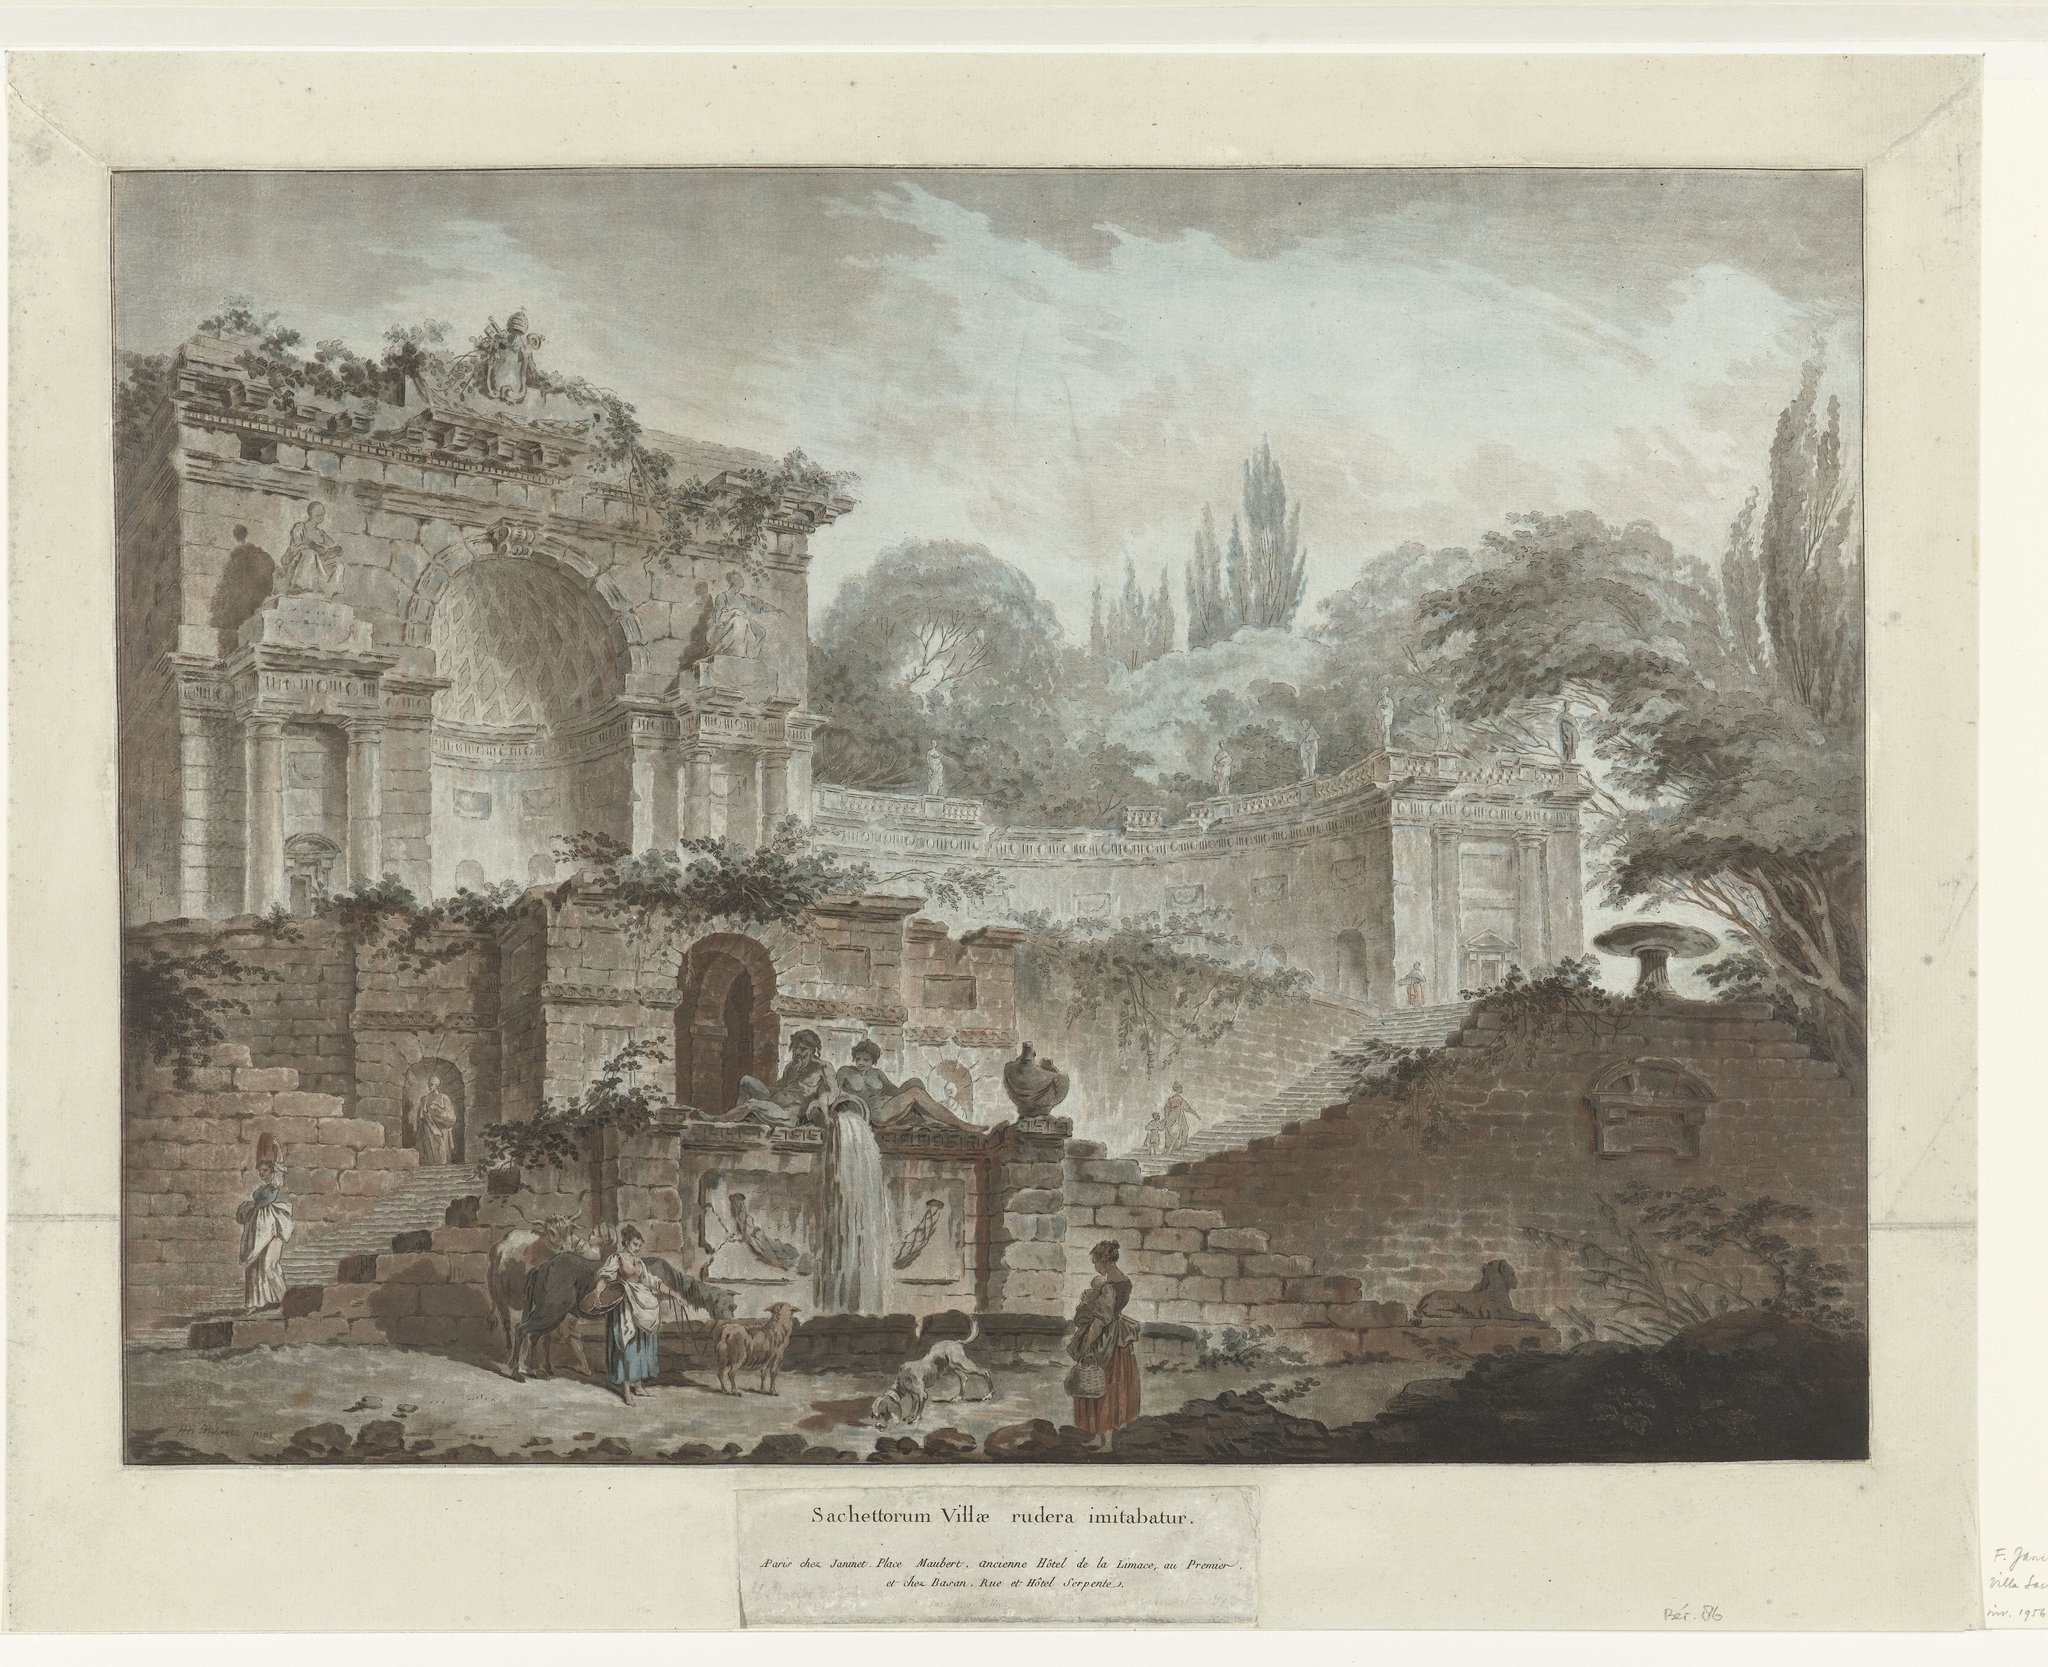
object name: print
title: Sachettorum Villae rundera imitabatur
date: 1778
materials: paper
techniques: aquatint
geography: paris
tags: garden fountain, villa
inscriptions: collector's mark: Lugt 2964, collector's mark: Lugt 2228, collector's mark: Lugt 2760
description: De fontein in het park van de Villa Sacchetti, een aantal mensen en dieren rondom het bassin. Onderschrift losgesneden.